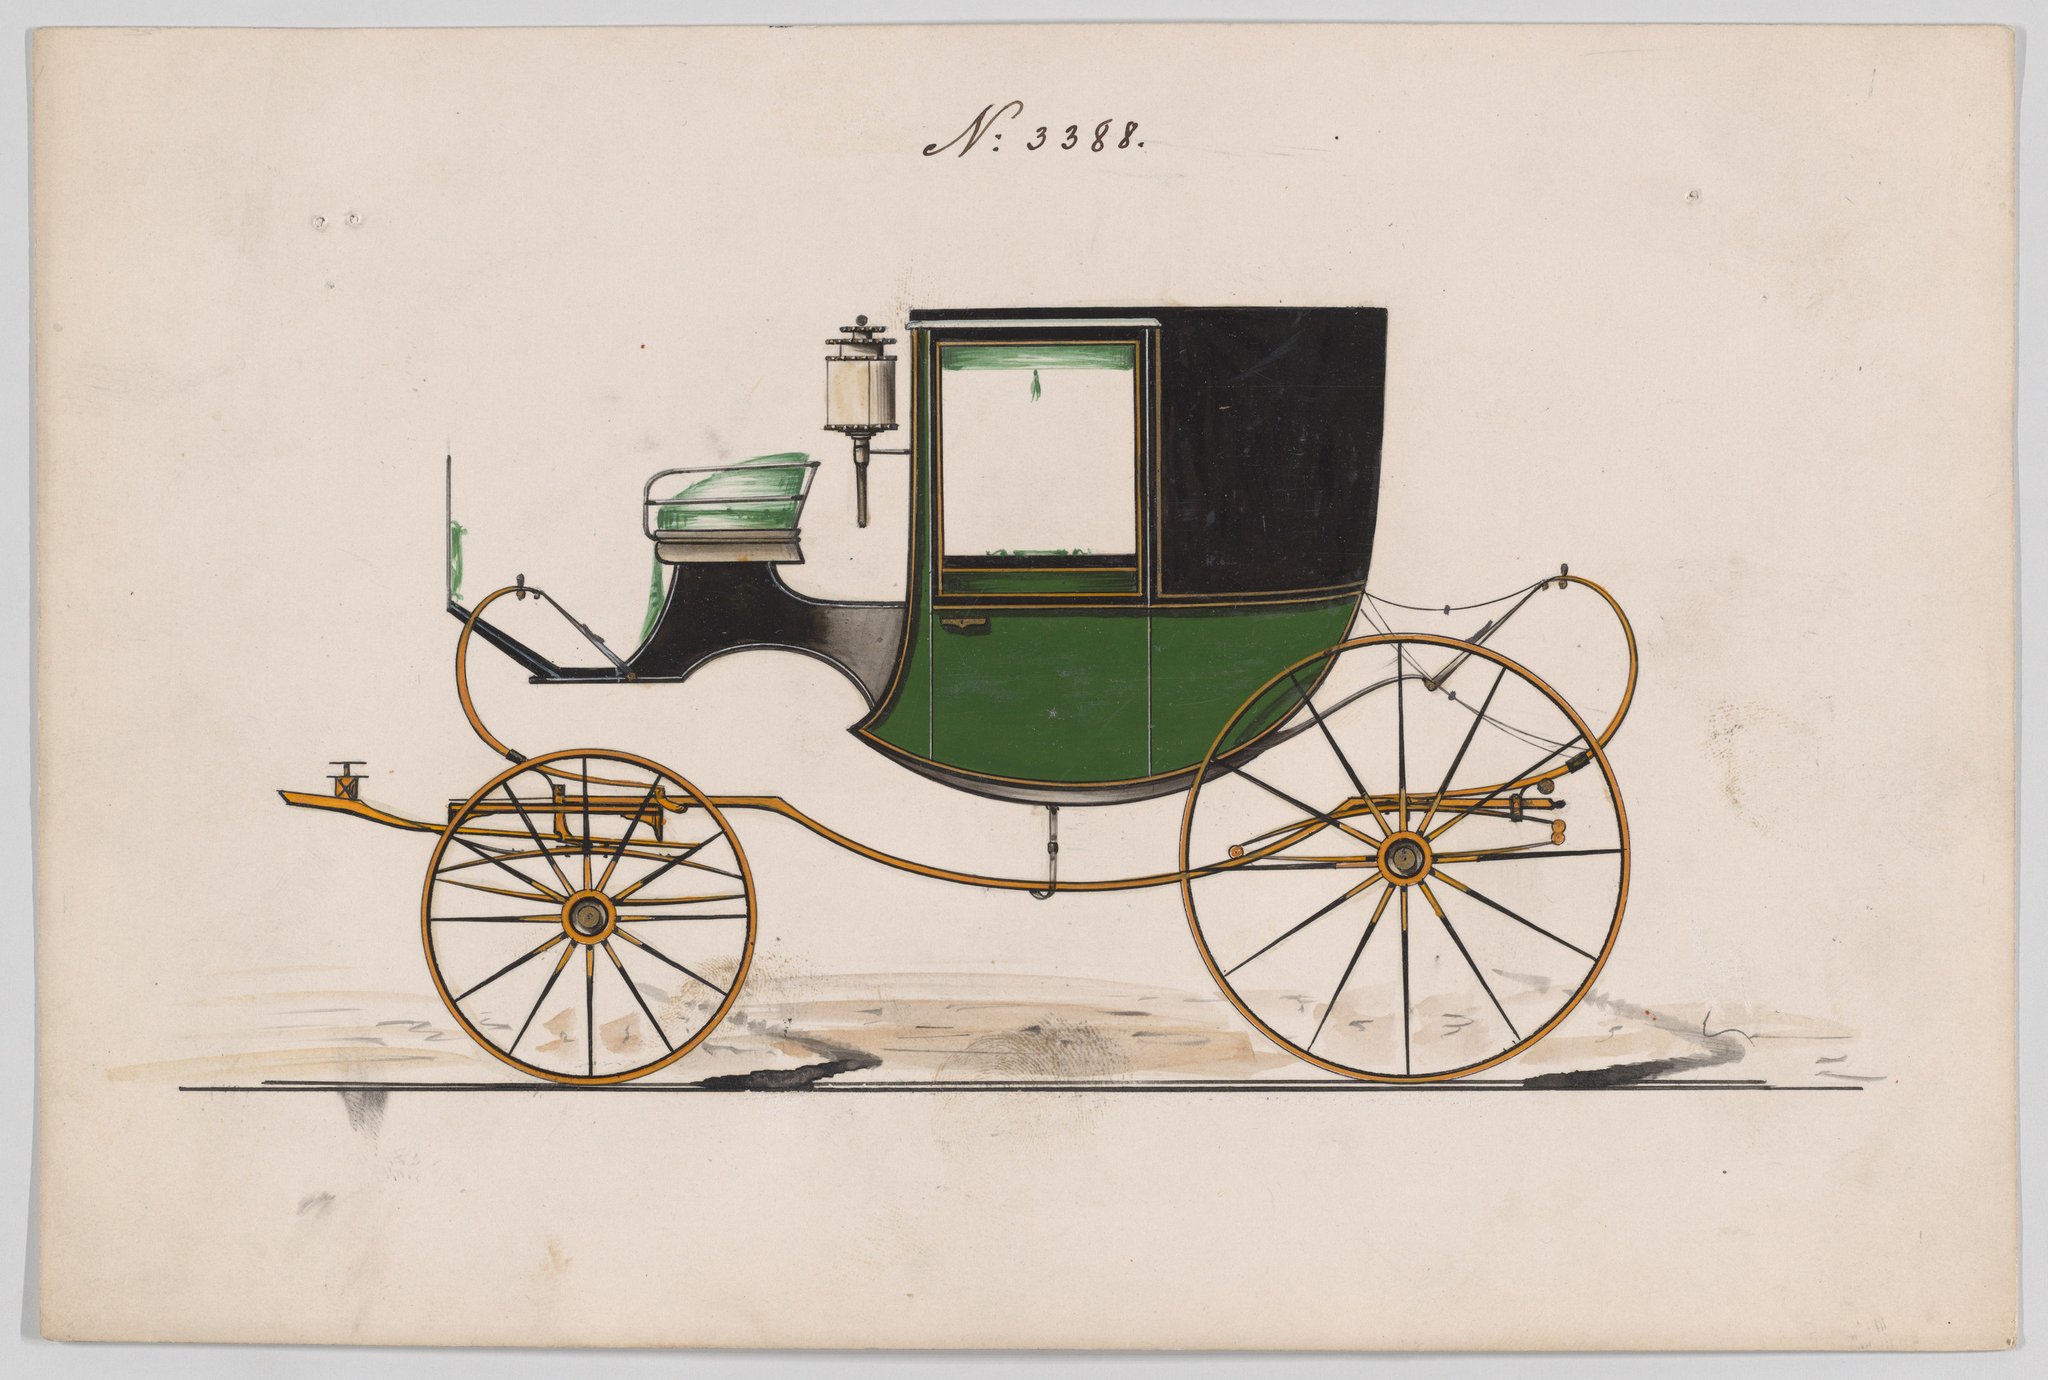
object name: drawing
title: Chariot #3388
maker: brewster & co.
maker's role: manufacturer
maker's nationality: american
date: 1878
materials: gouache, gum arabic, ink, watercolor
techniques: pen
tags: carriages